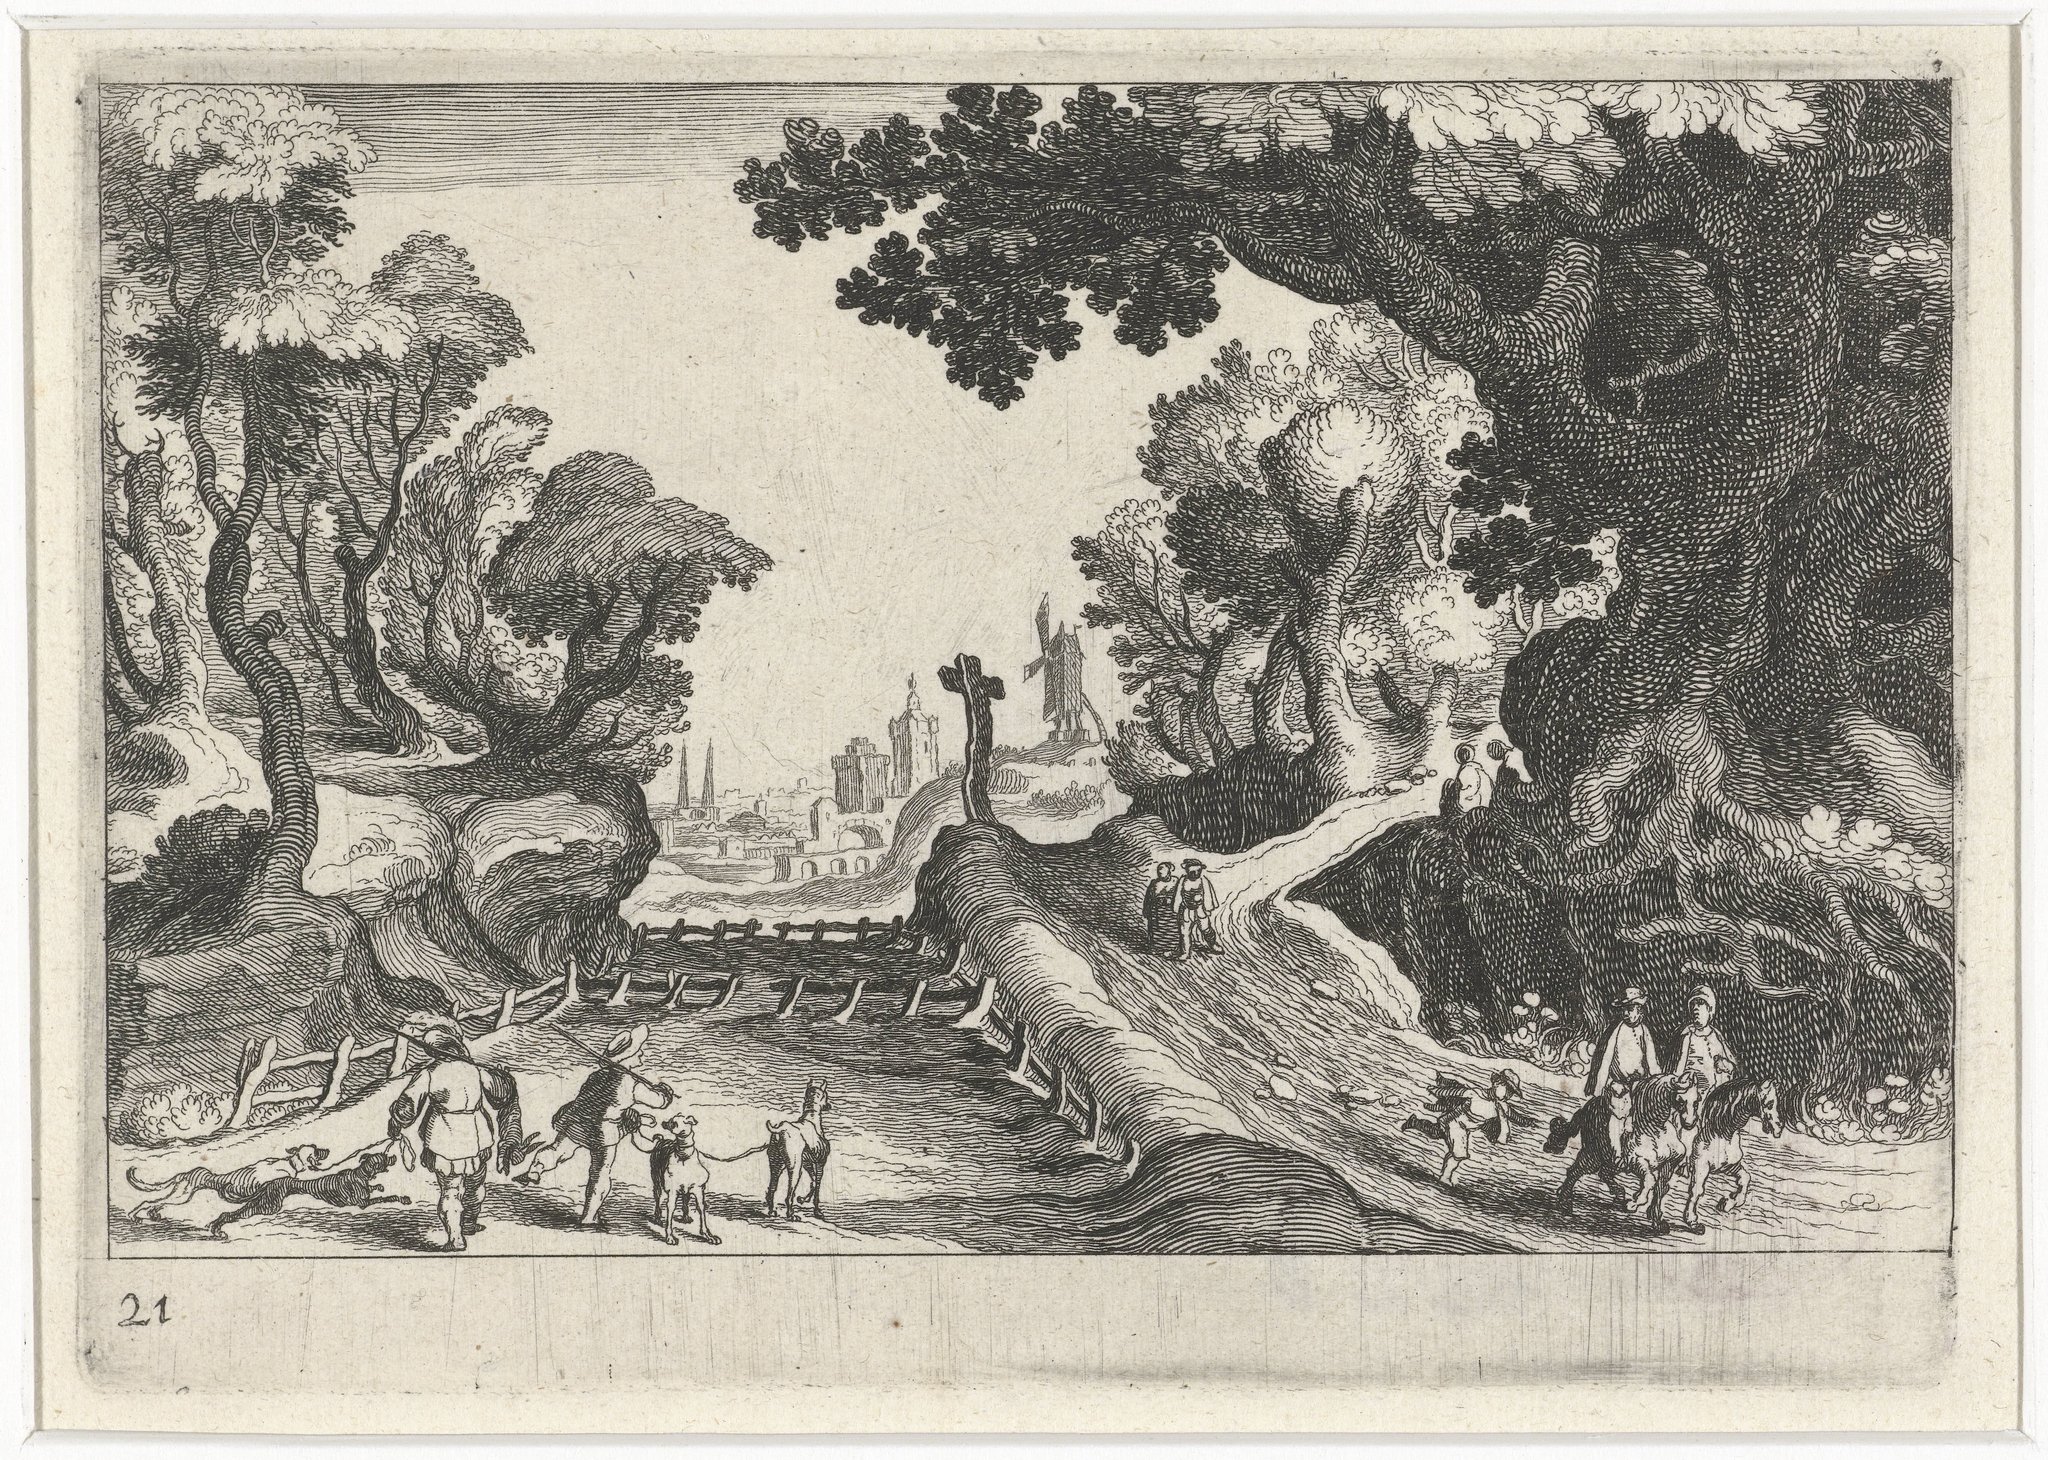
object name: print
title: Zuid-Europese landschappen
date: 1611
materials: paper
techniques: etching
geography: northern netherlands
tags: landscapes (+ landscape with figures, staffage)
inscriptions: collector's mark: Lugt 240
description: Boslandschap met diverse figuren, onder wie twee jagers, bij een pad met een groot kruis. Op de achtergrond een molen en een stadsgezicht.